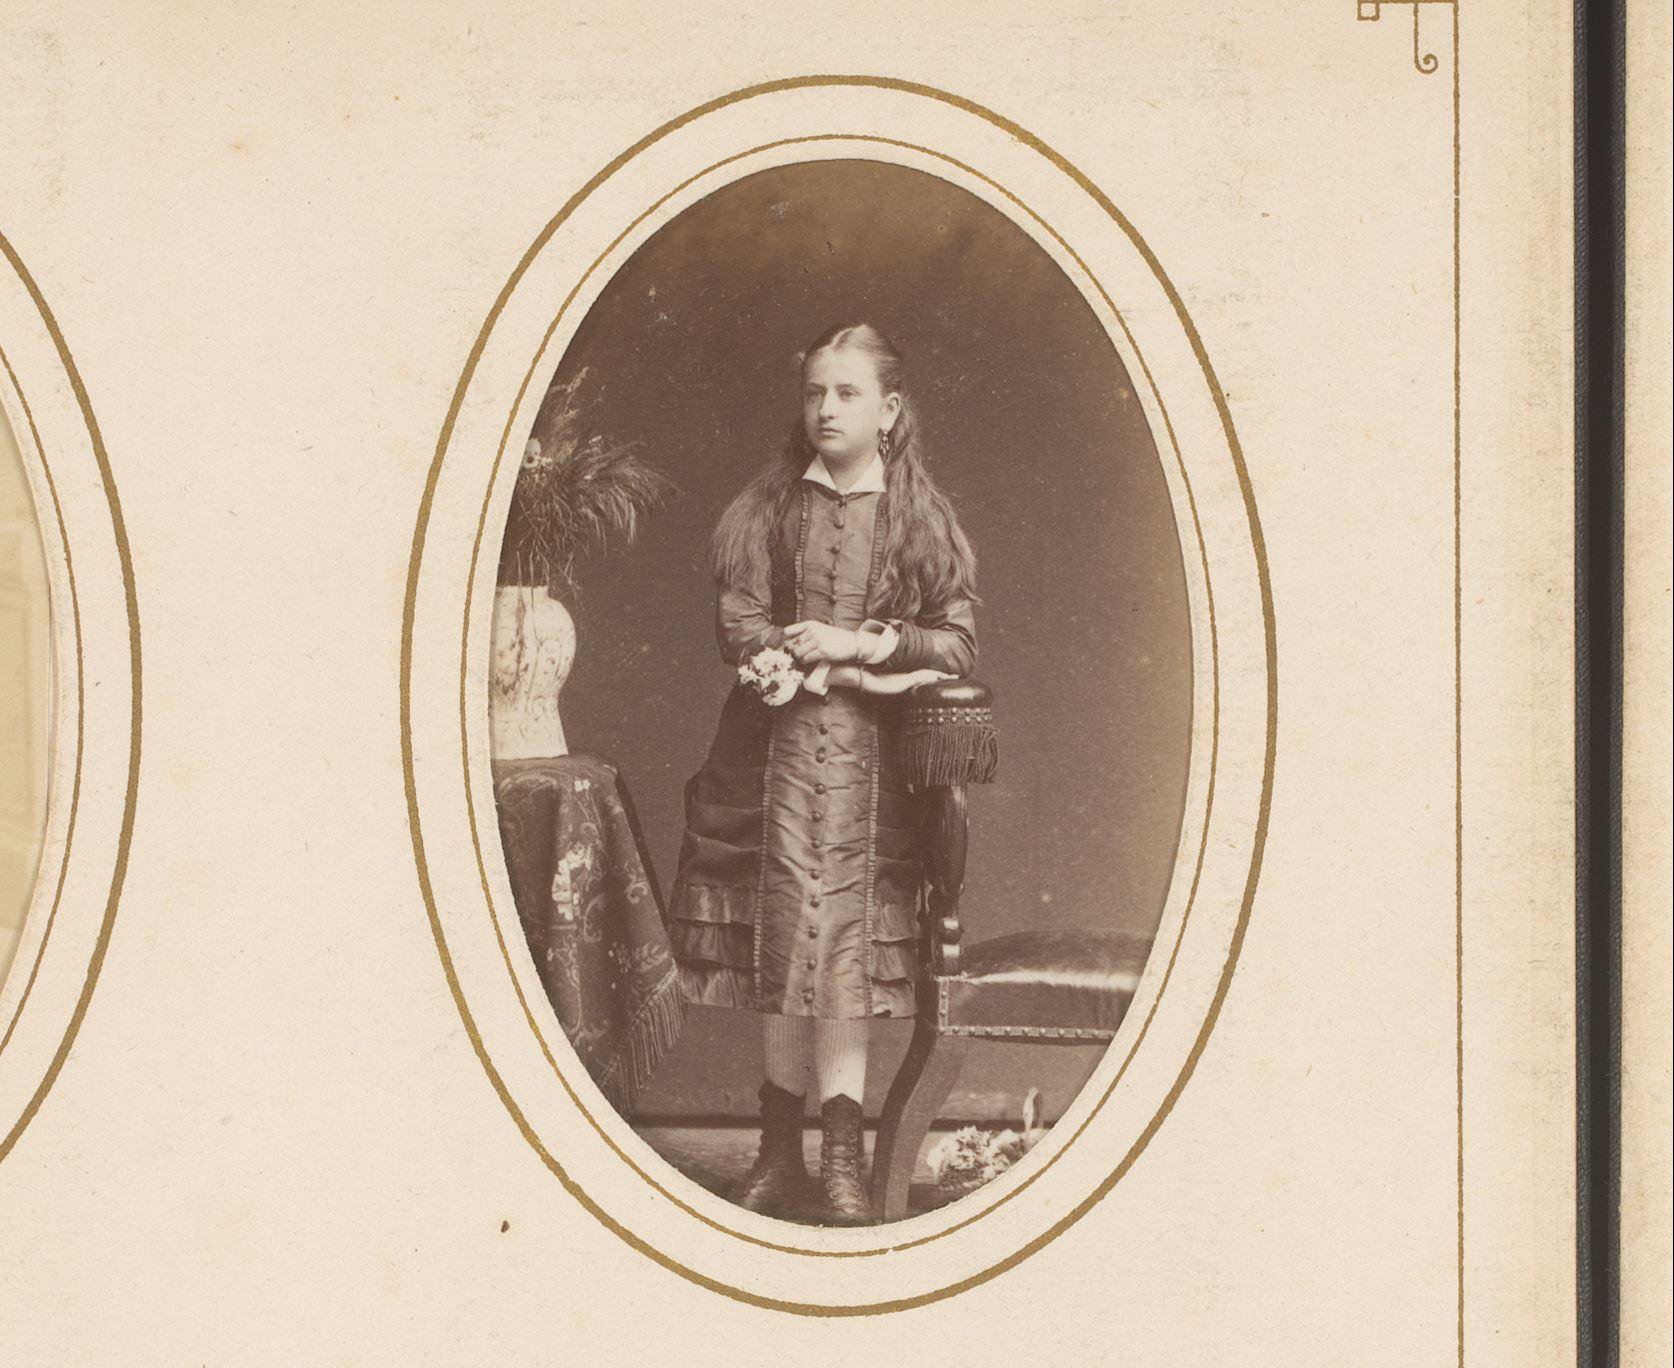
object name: carte de visite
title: Portret van een staand meisje, leunend op de leuning van een stoel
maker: eugene guérin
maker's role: fotograaf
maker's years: 1845-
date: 1878-1885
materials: cardboard, photographic support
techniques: albumen print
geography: brussels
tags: historical persons - bb - woman, girl (child between toddler and youth), chair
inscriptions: inscription: ‘MÉDAILLE D'OR NAPLES 1874/ MENTION HONORABLE EXPon UNIVle PARIS 1878/ Eugène Guérin/ 142, Rue Royale, 142/ Bruxelles’